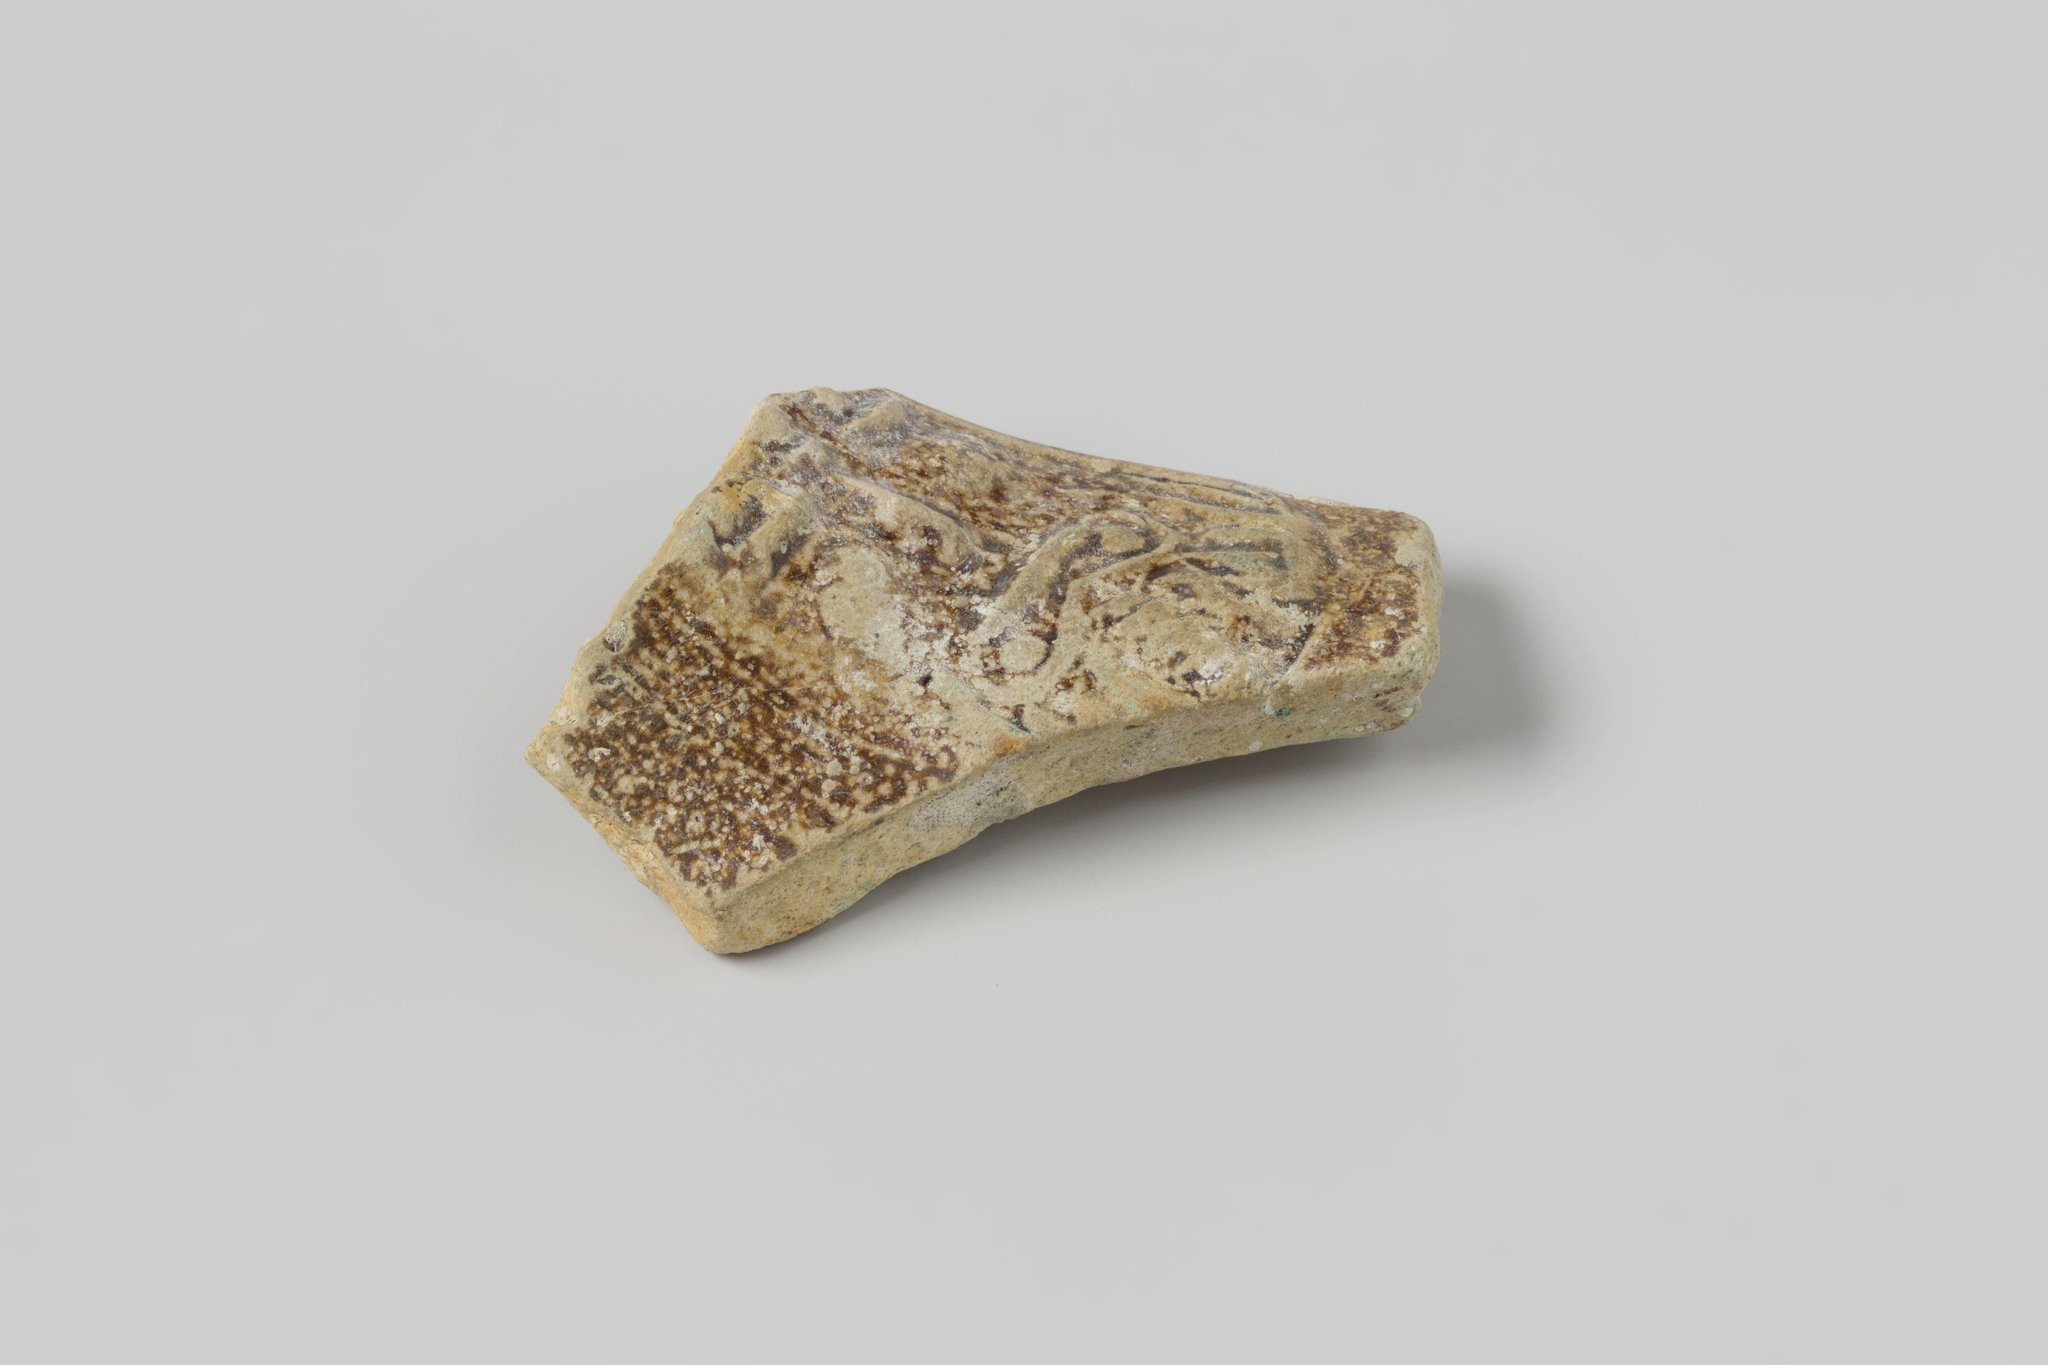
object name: sherd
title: Scherf van een kan uit het wrak van de Oost-Indiëvaarder Hollandia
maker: Anonymous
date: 1700-1743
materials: stoneware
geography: cologne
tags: verenigde oostindische compagnie, hollandia (schip), annet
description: Stoneware, Rhenish, Frechen-ware, jug; fragm of bellarmine mask-appliqué, sim. NG 1980-27H2024.